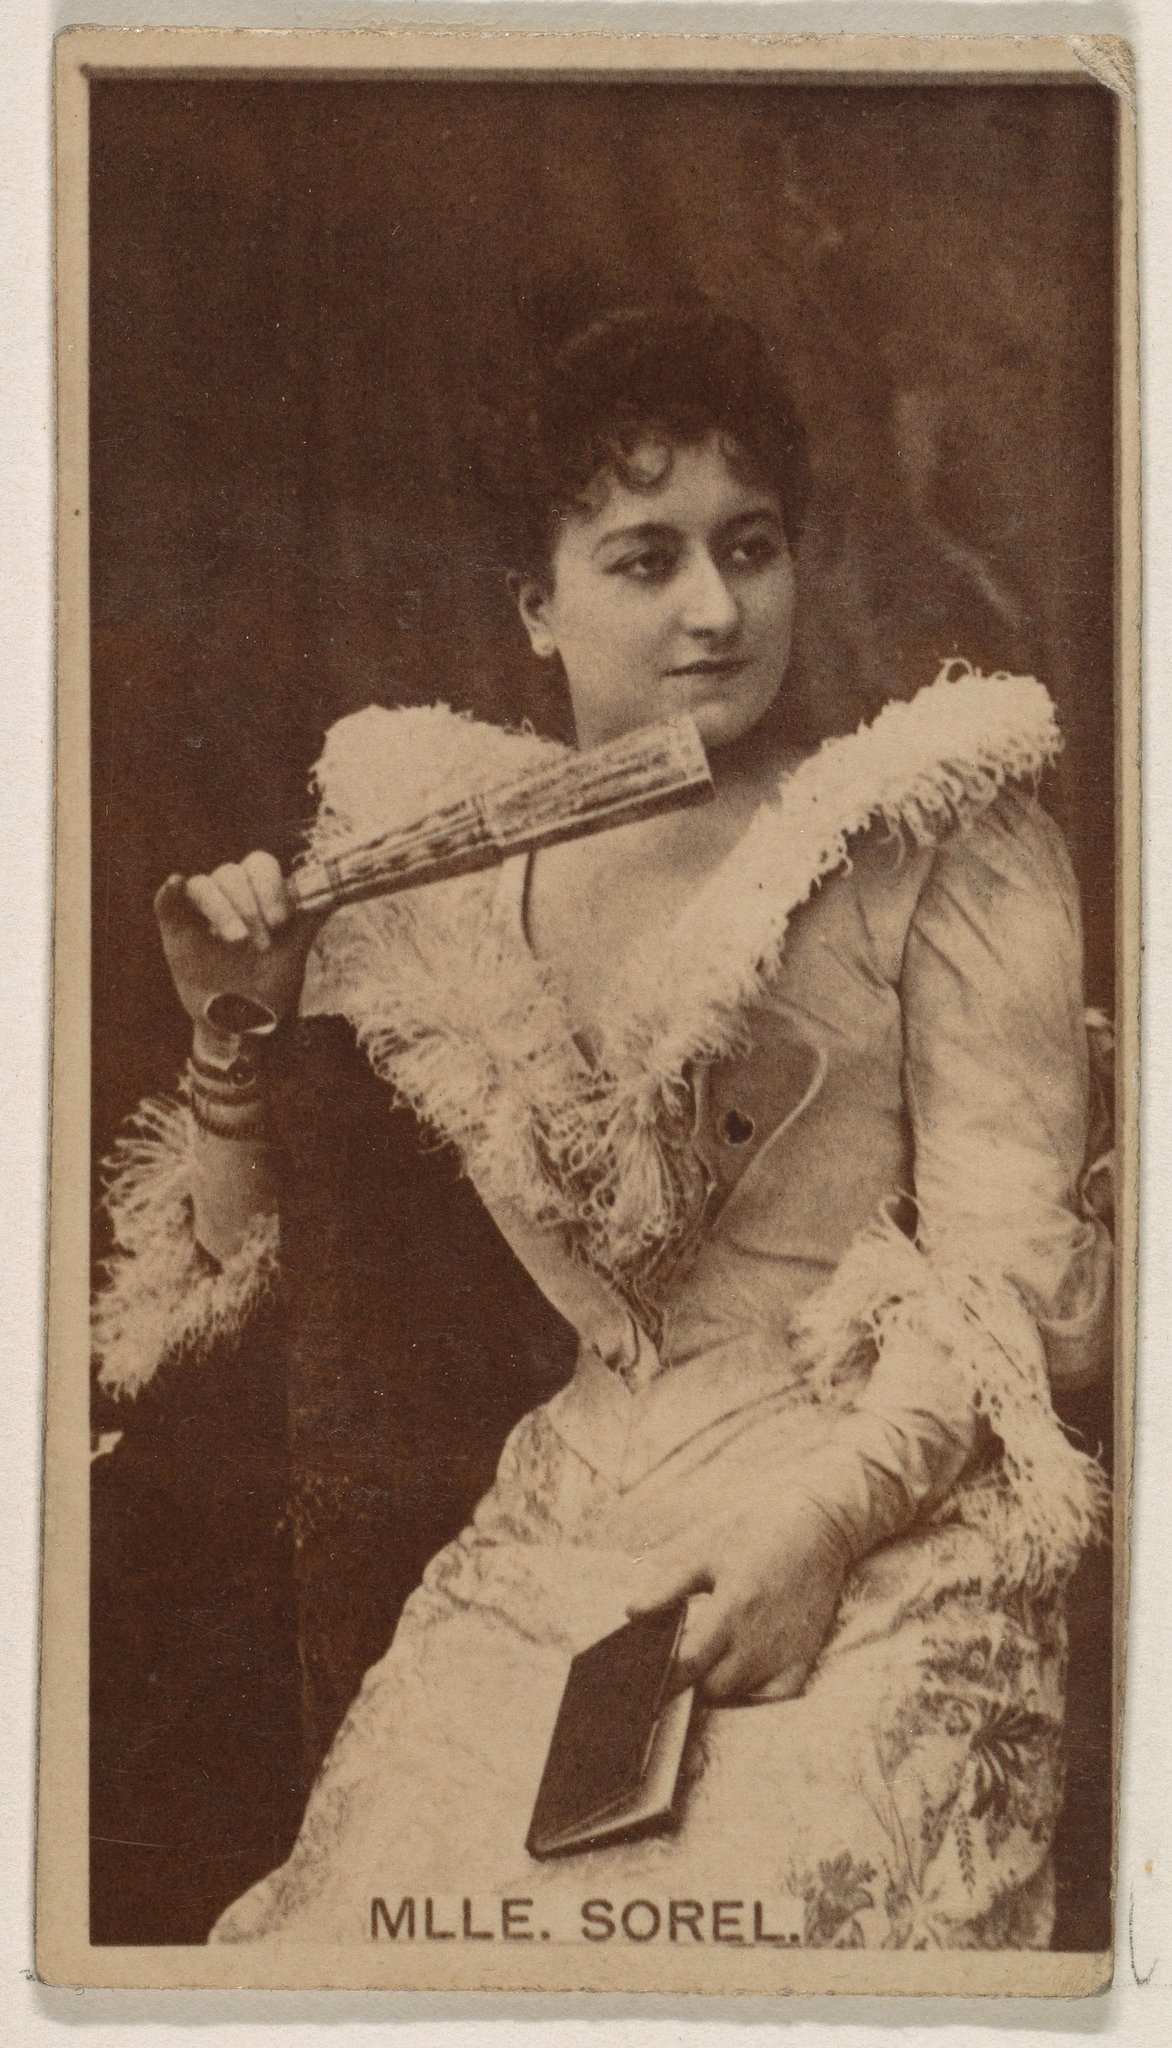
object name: photograph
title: Mlle. Sorel, from the Actresses series (N245) issued by Kinney Brothers to promote Sweet Caporal Cigarettes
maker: kinney brothers tobacco company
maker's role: publisher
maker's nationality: american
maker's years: 1869-2011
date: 1890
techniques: albumen silver print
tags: portraits,women,actresses